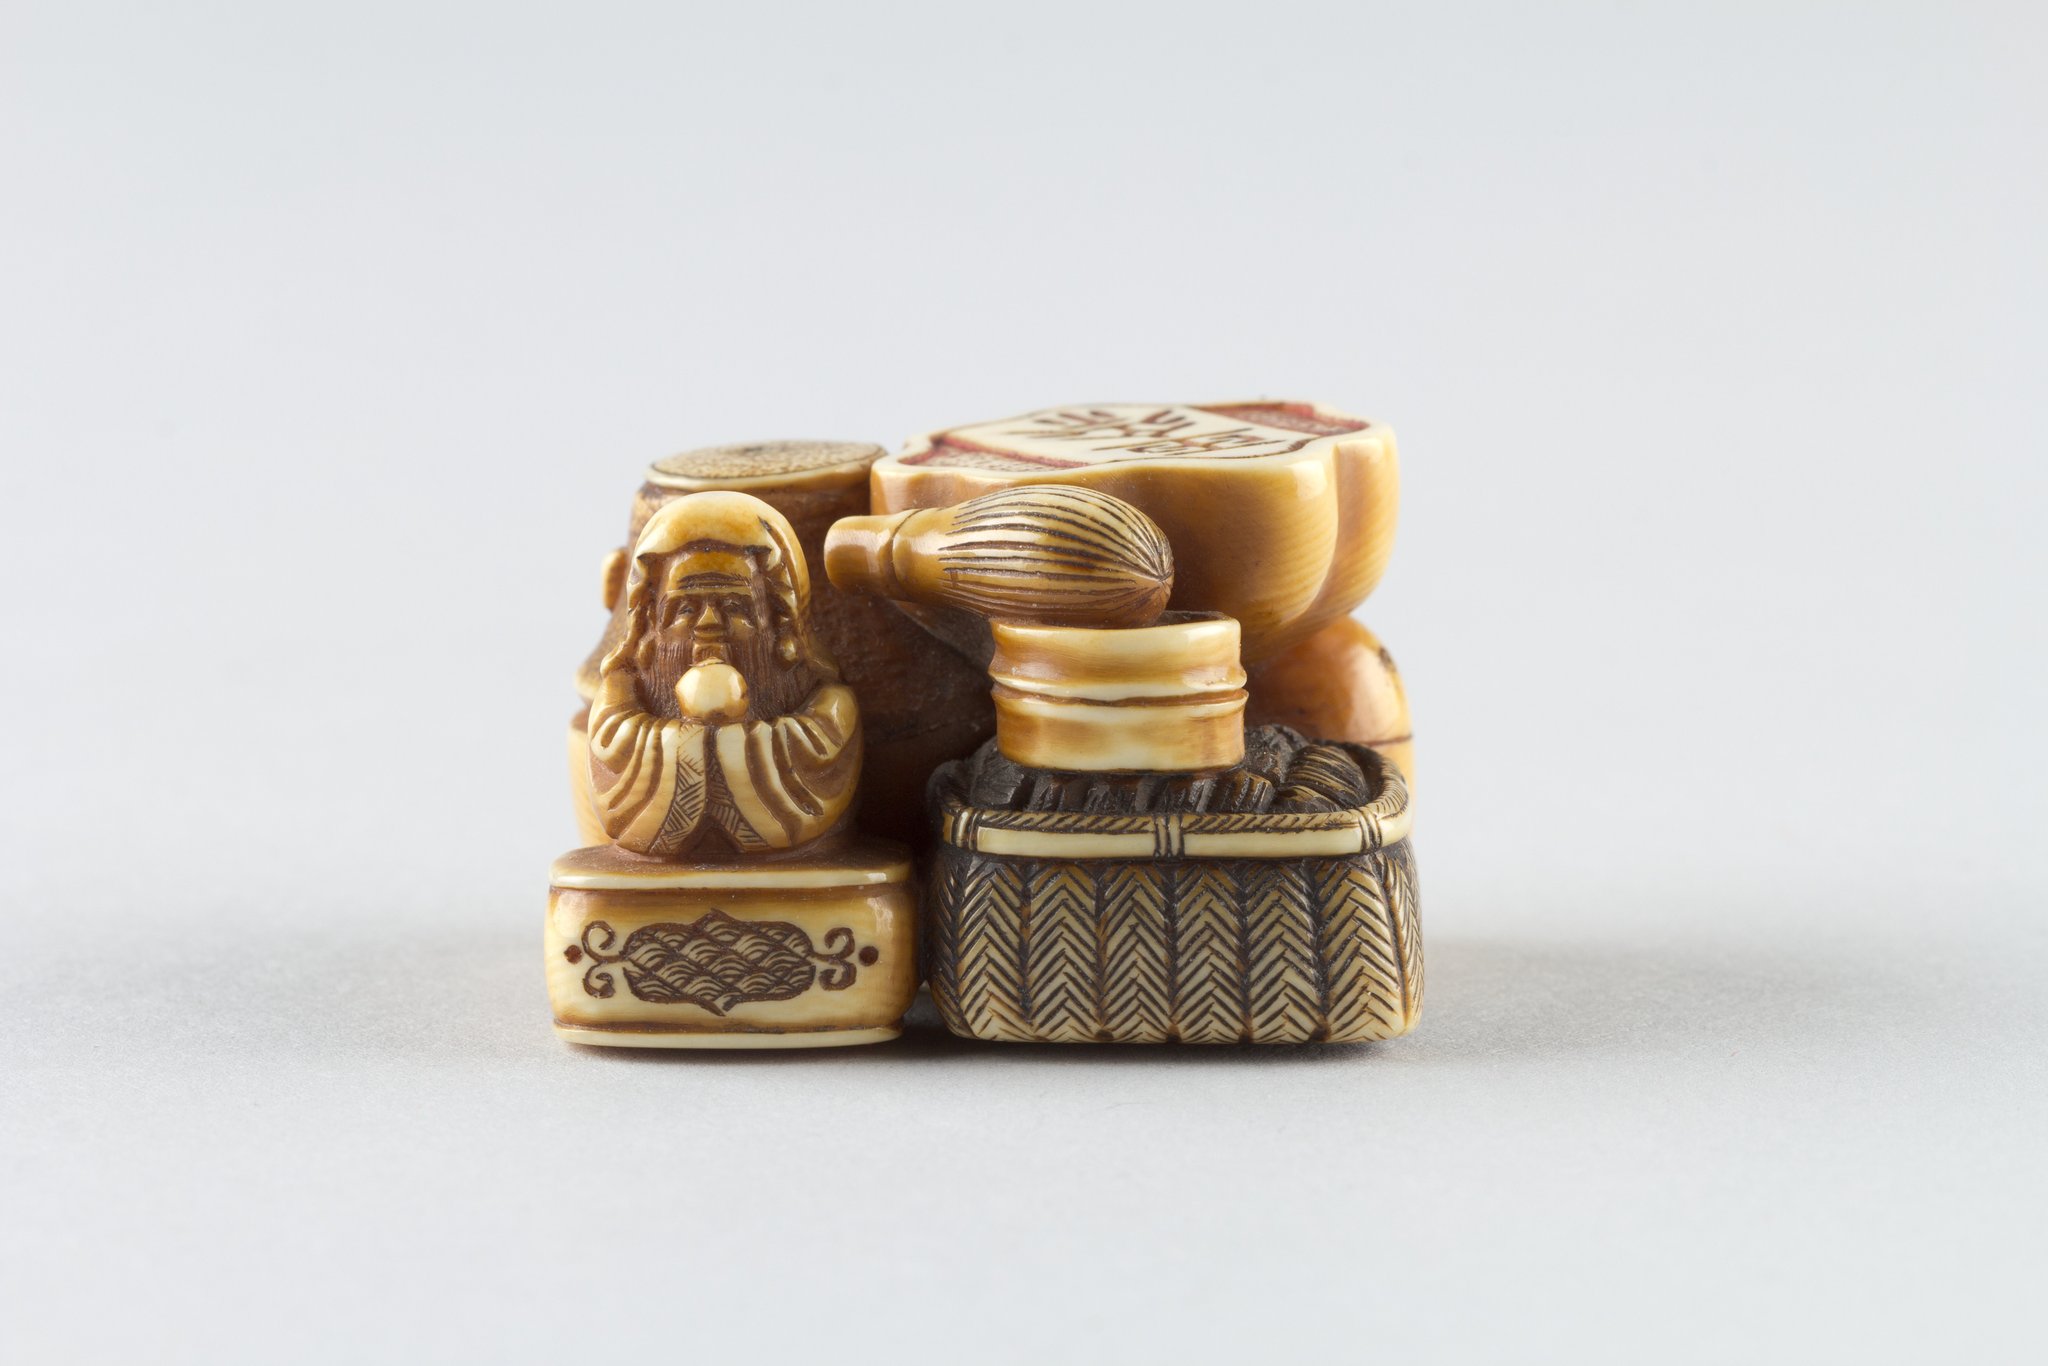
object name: netsuke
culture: japanese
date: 1701-1800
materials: ivory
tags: men